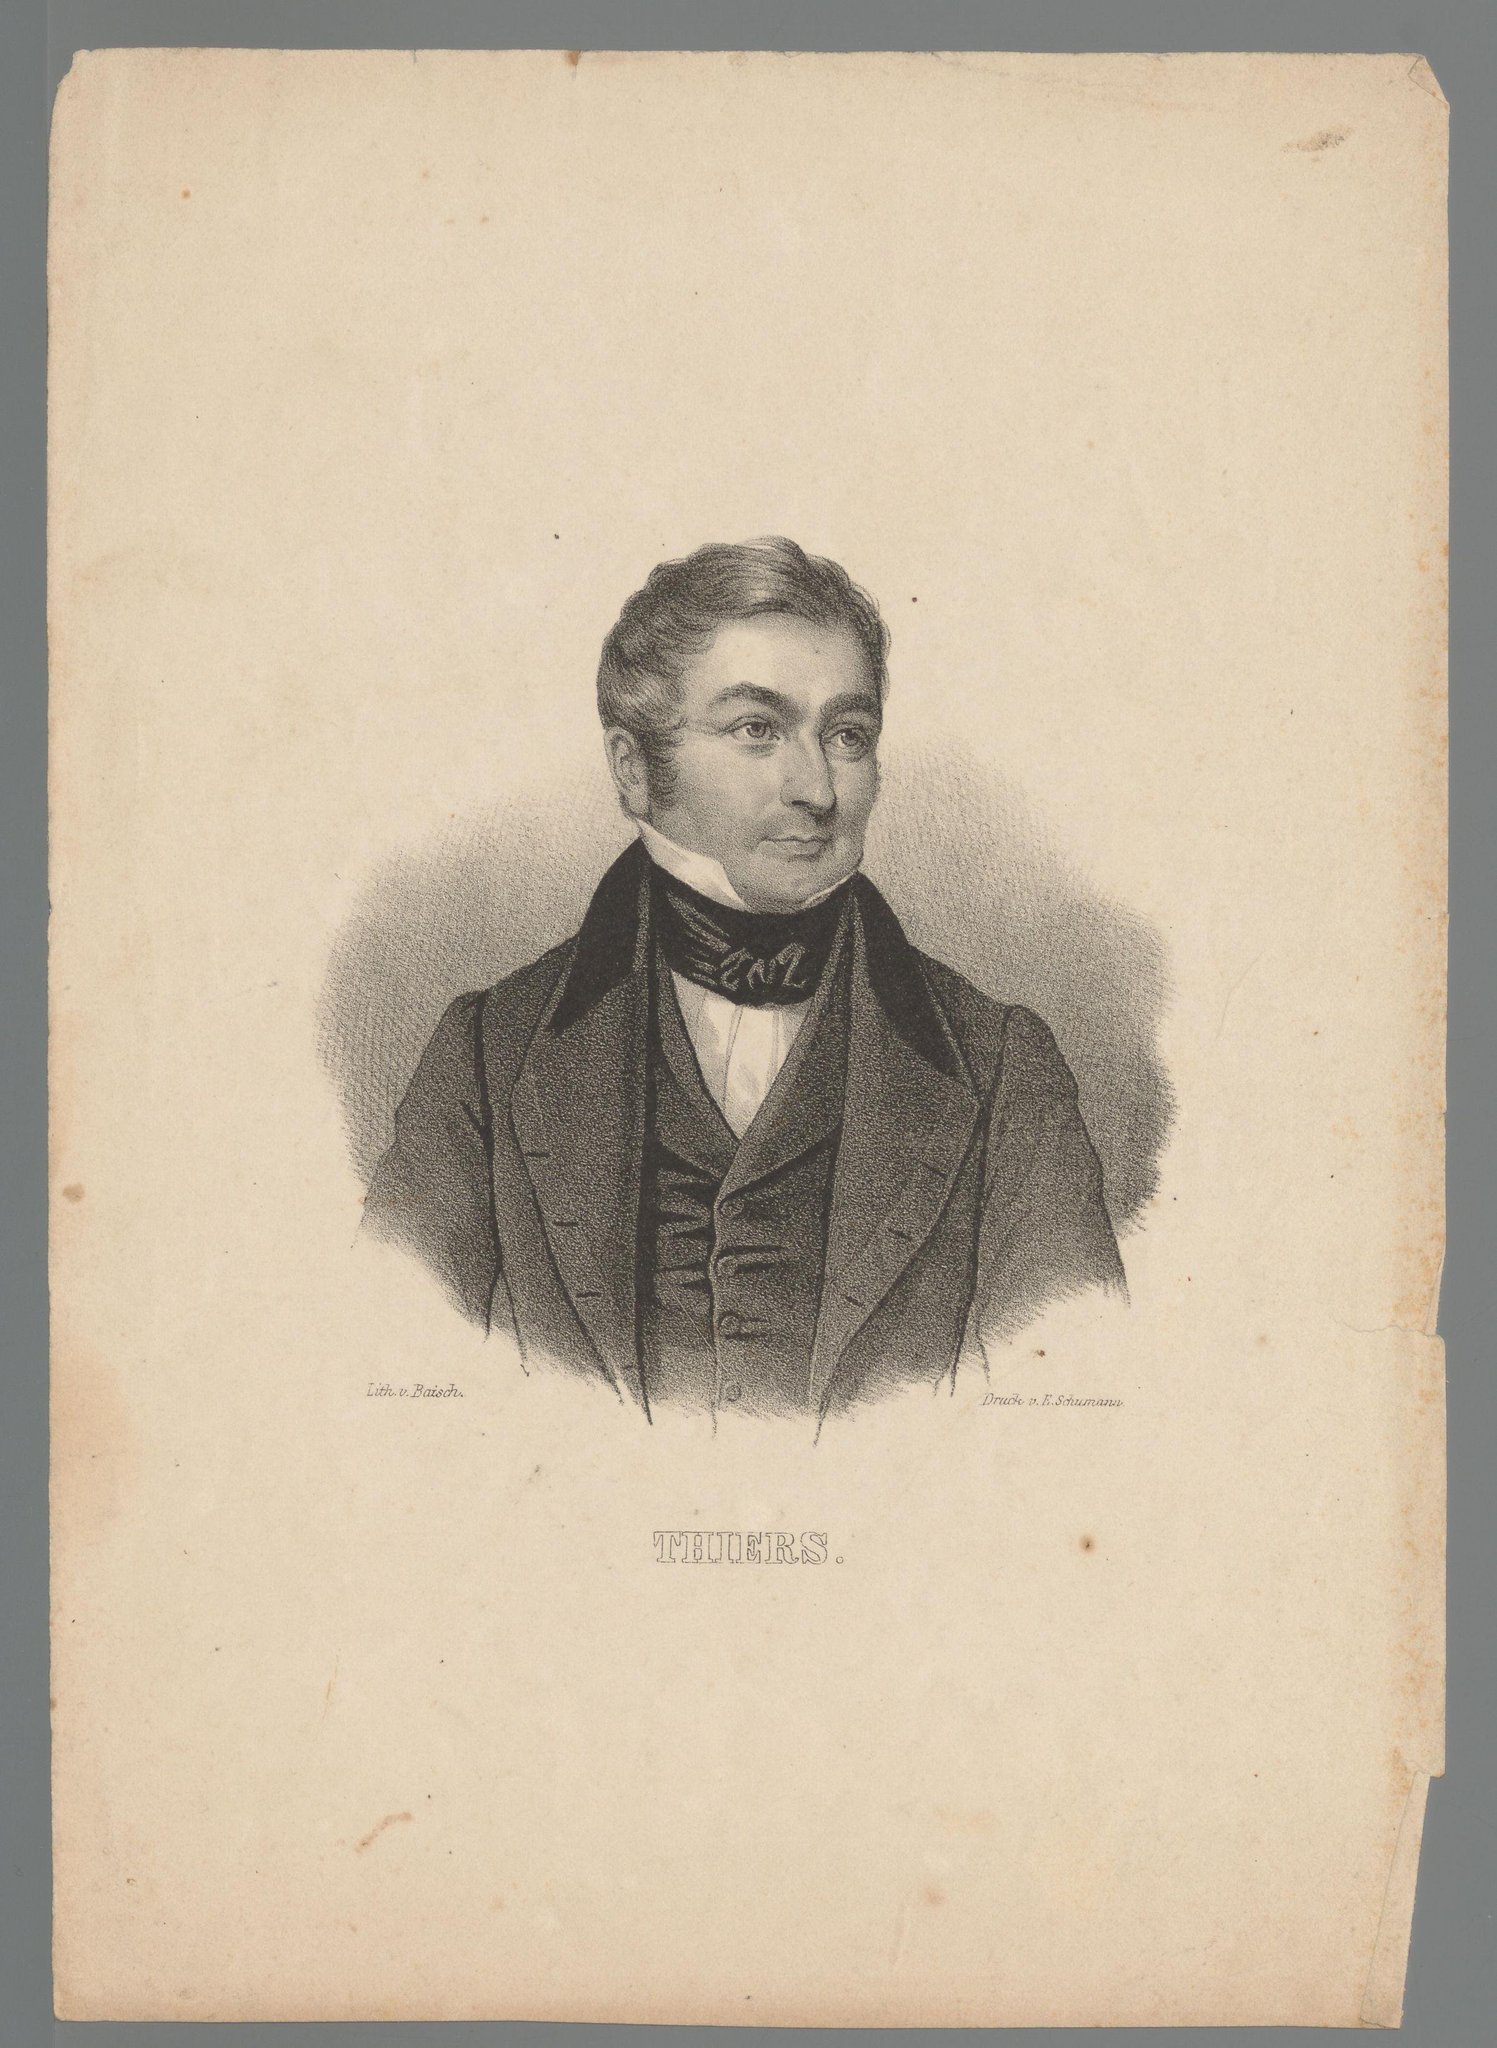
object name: print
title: Portret van Adolphe Thiers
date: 1815-1864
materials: paper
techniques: lithograph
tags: marseille, politician, historical persons, politician, e.g. party leader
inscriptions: collector's mark: Lugt 2228